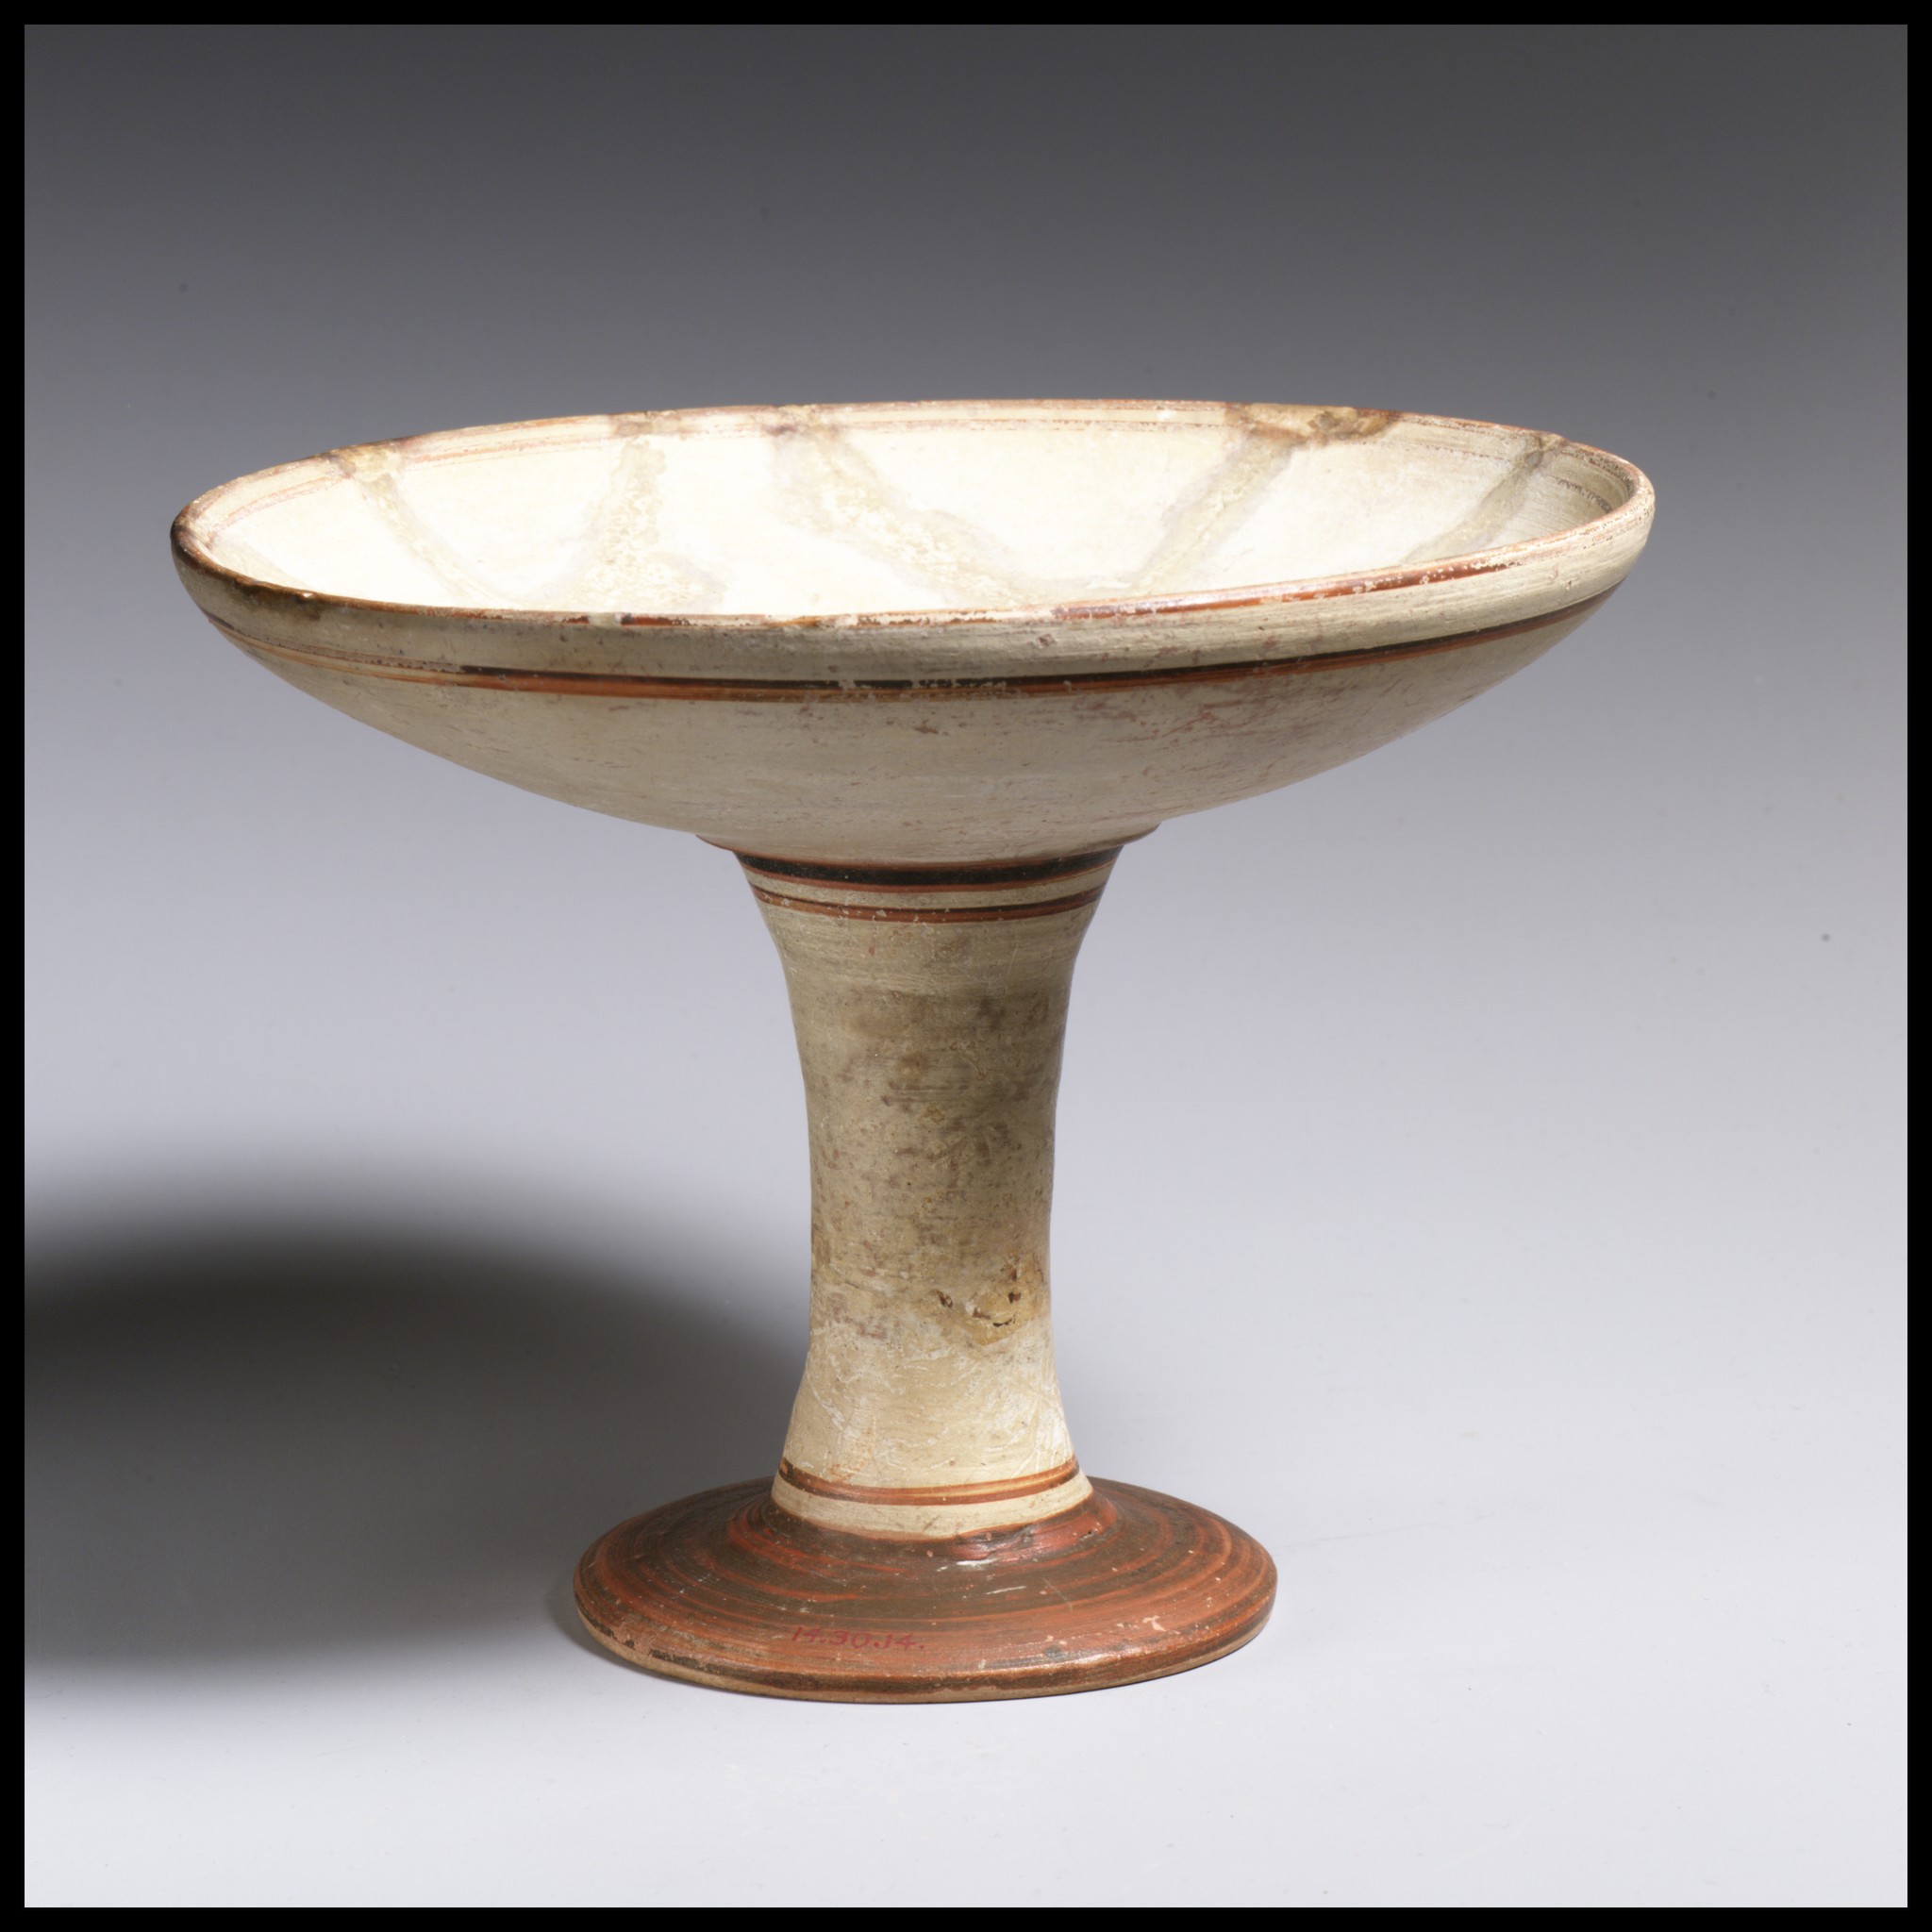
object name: bowl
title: Terracotta stemmed dish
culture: lydian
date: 600-501 BCE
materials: terracotta